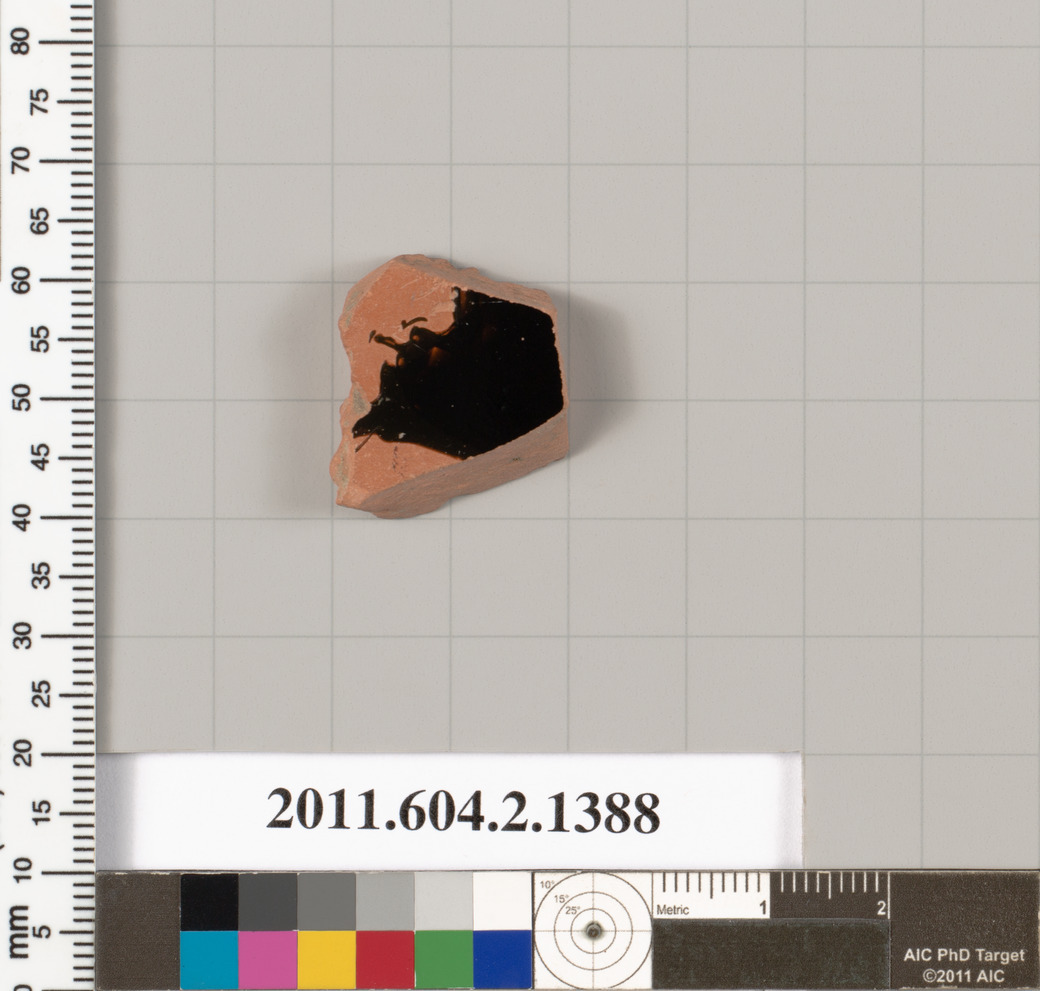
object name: skyphos fragment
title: Terracotta fragment of a skyphos (deep drinking cup)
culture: greek, attic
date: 460-450 BCE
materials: terracotta